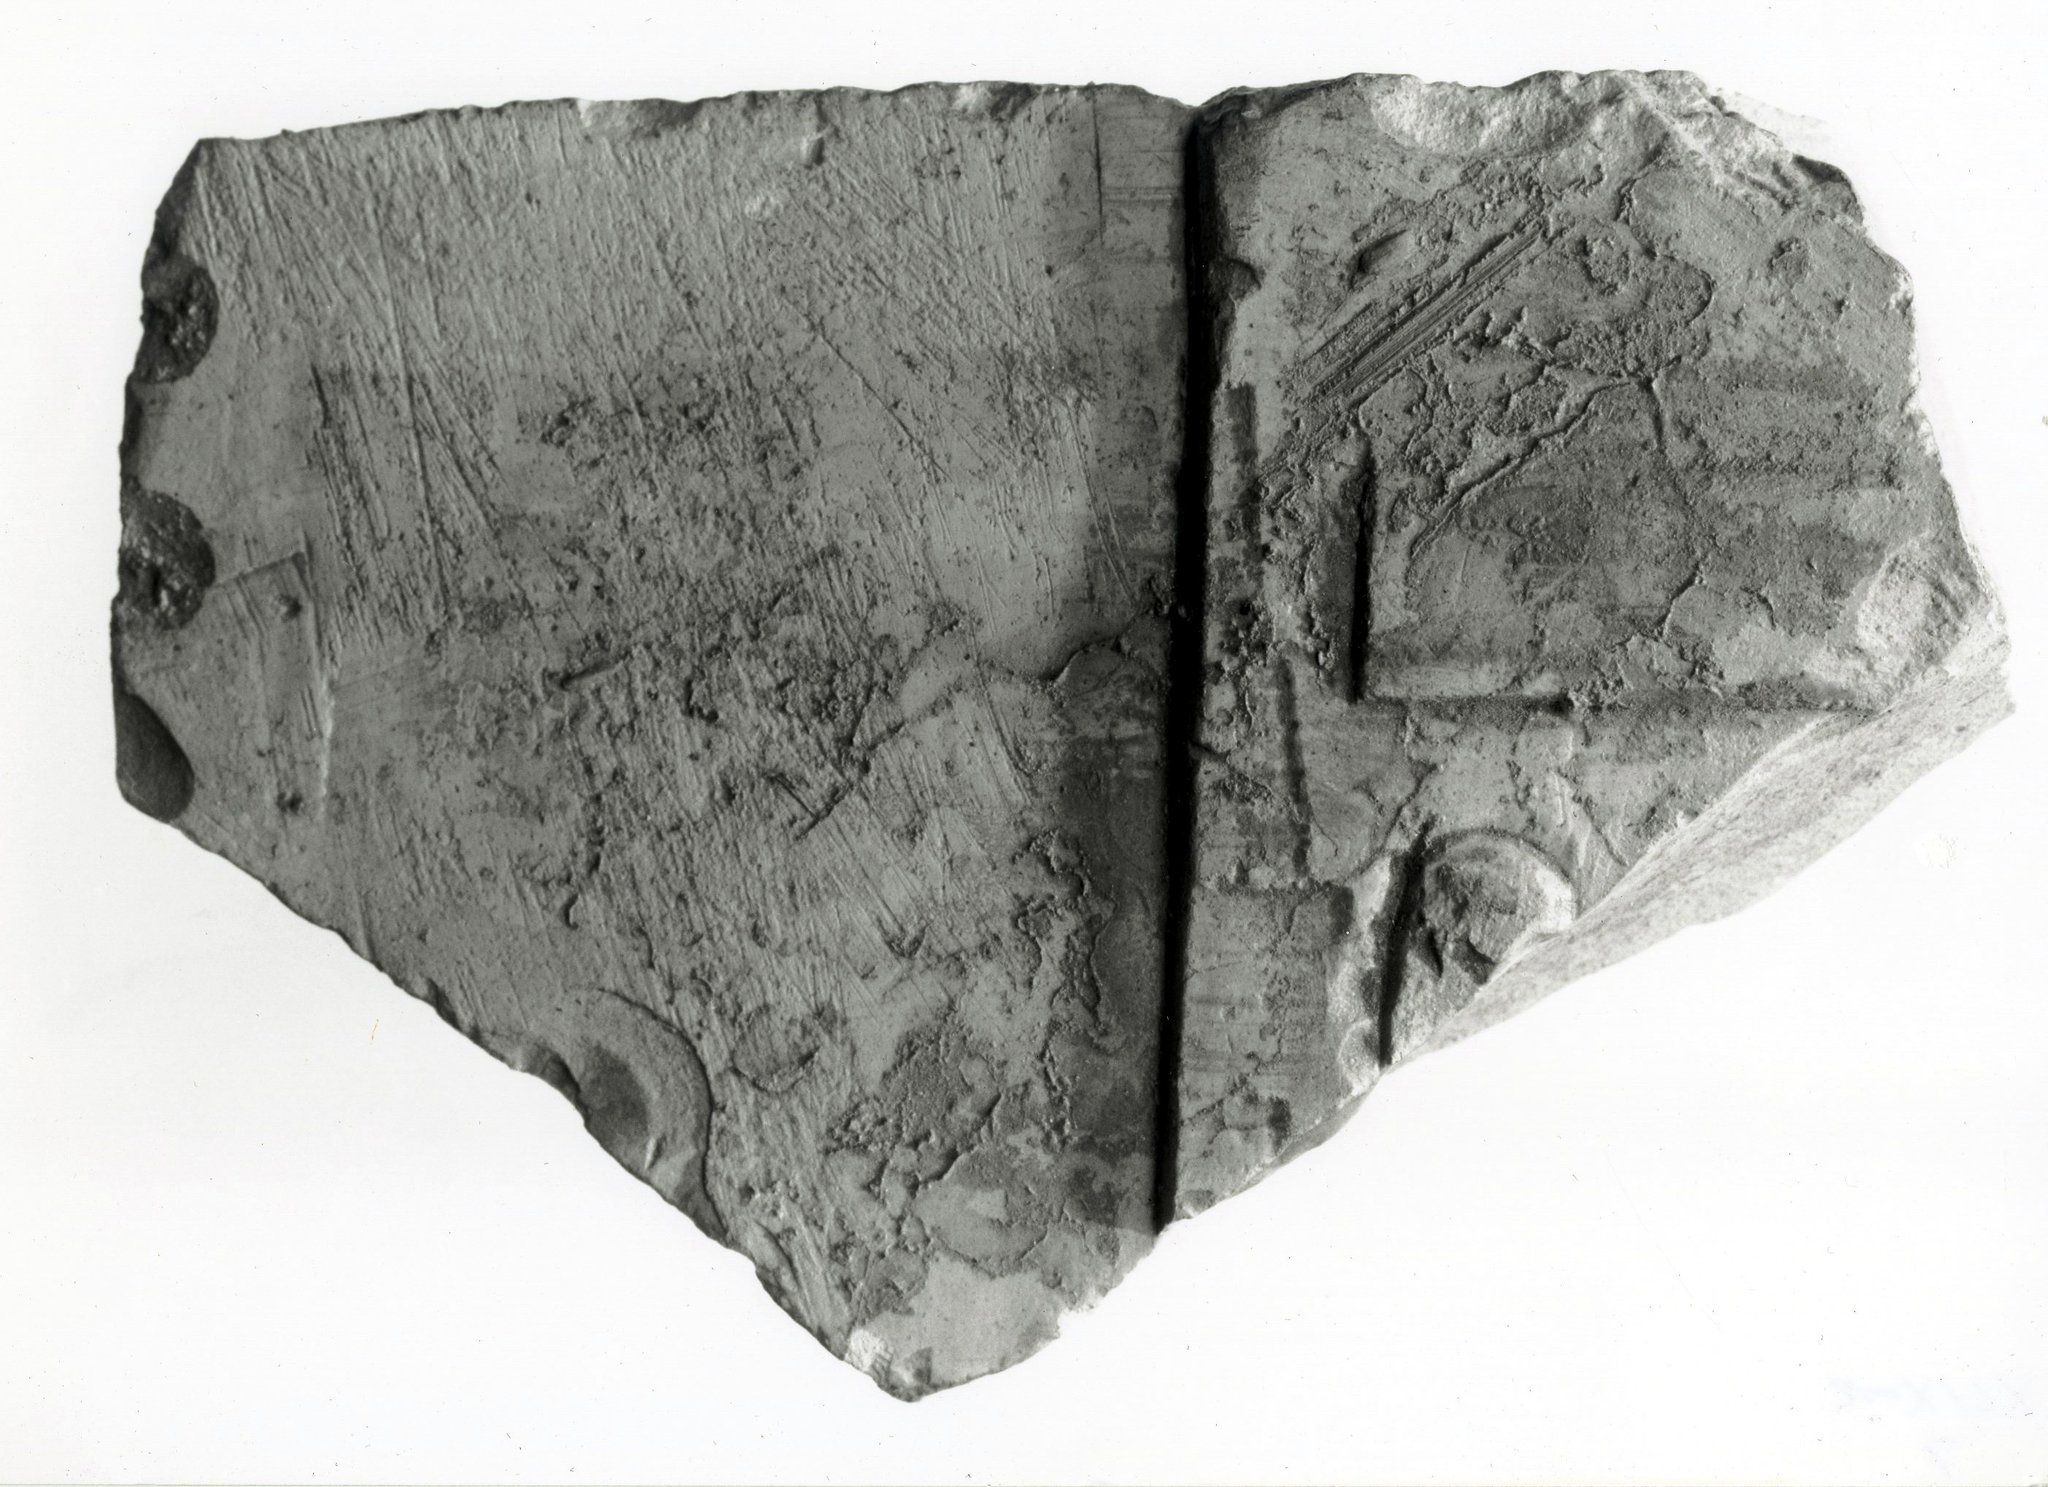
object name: relief, tomb of nespekashuty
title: Raised relief fragment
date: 664-610 BCE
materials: limestone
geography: egypt